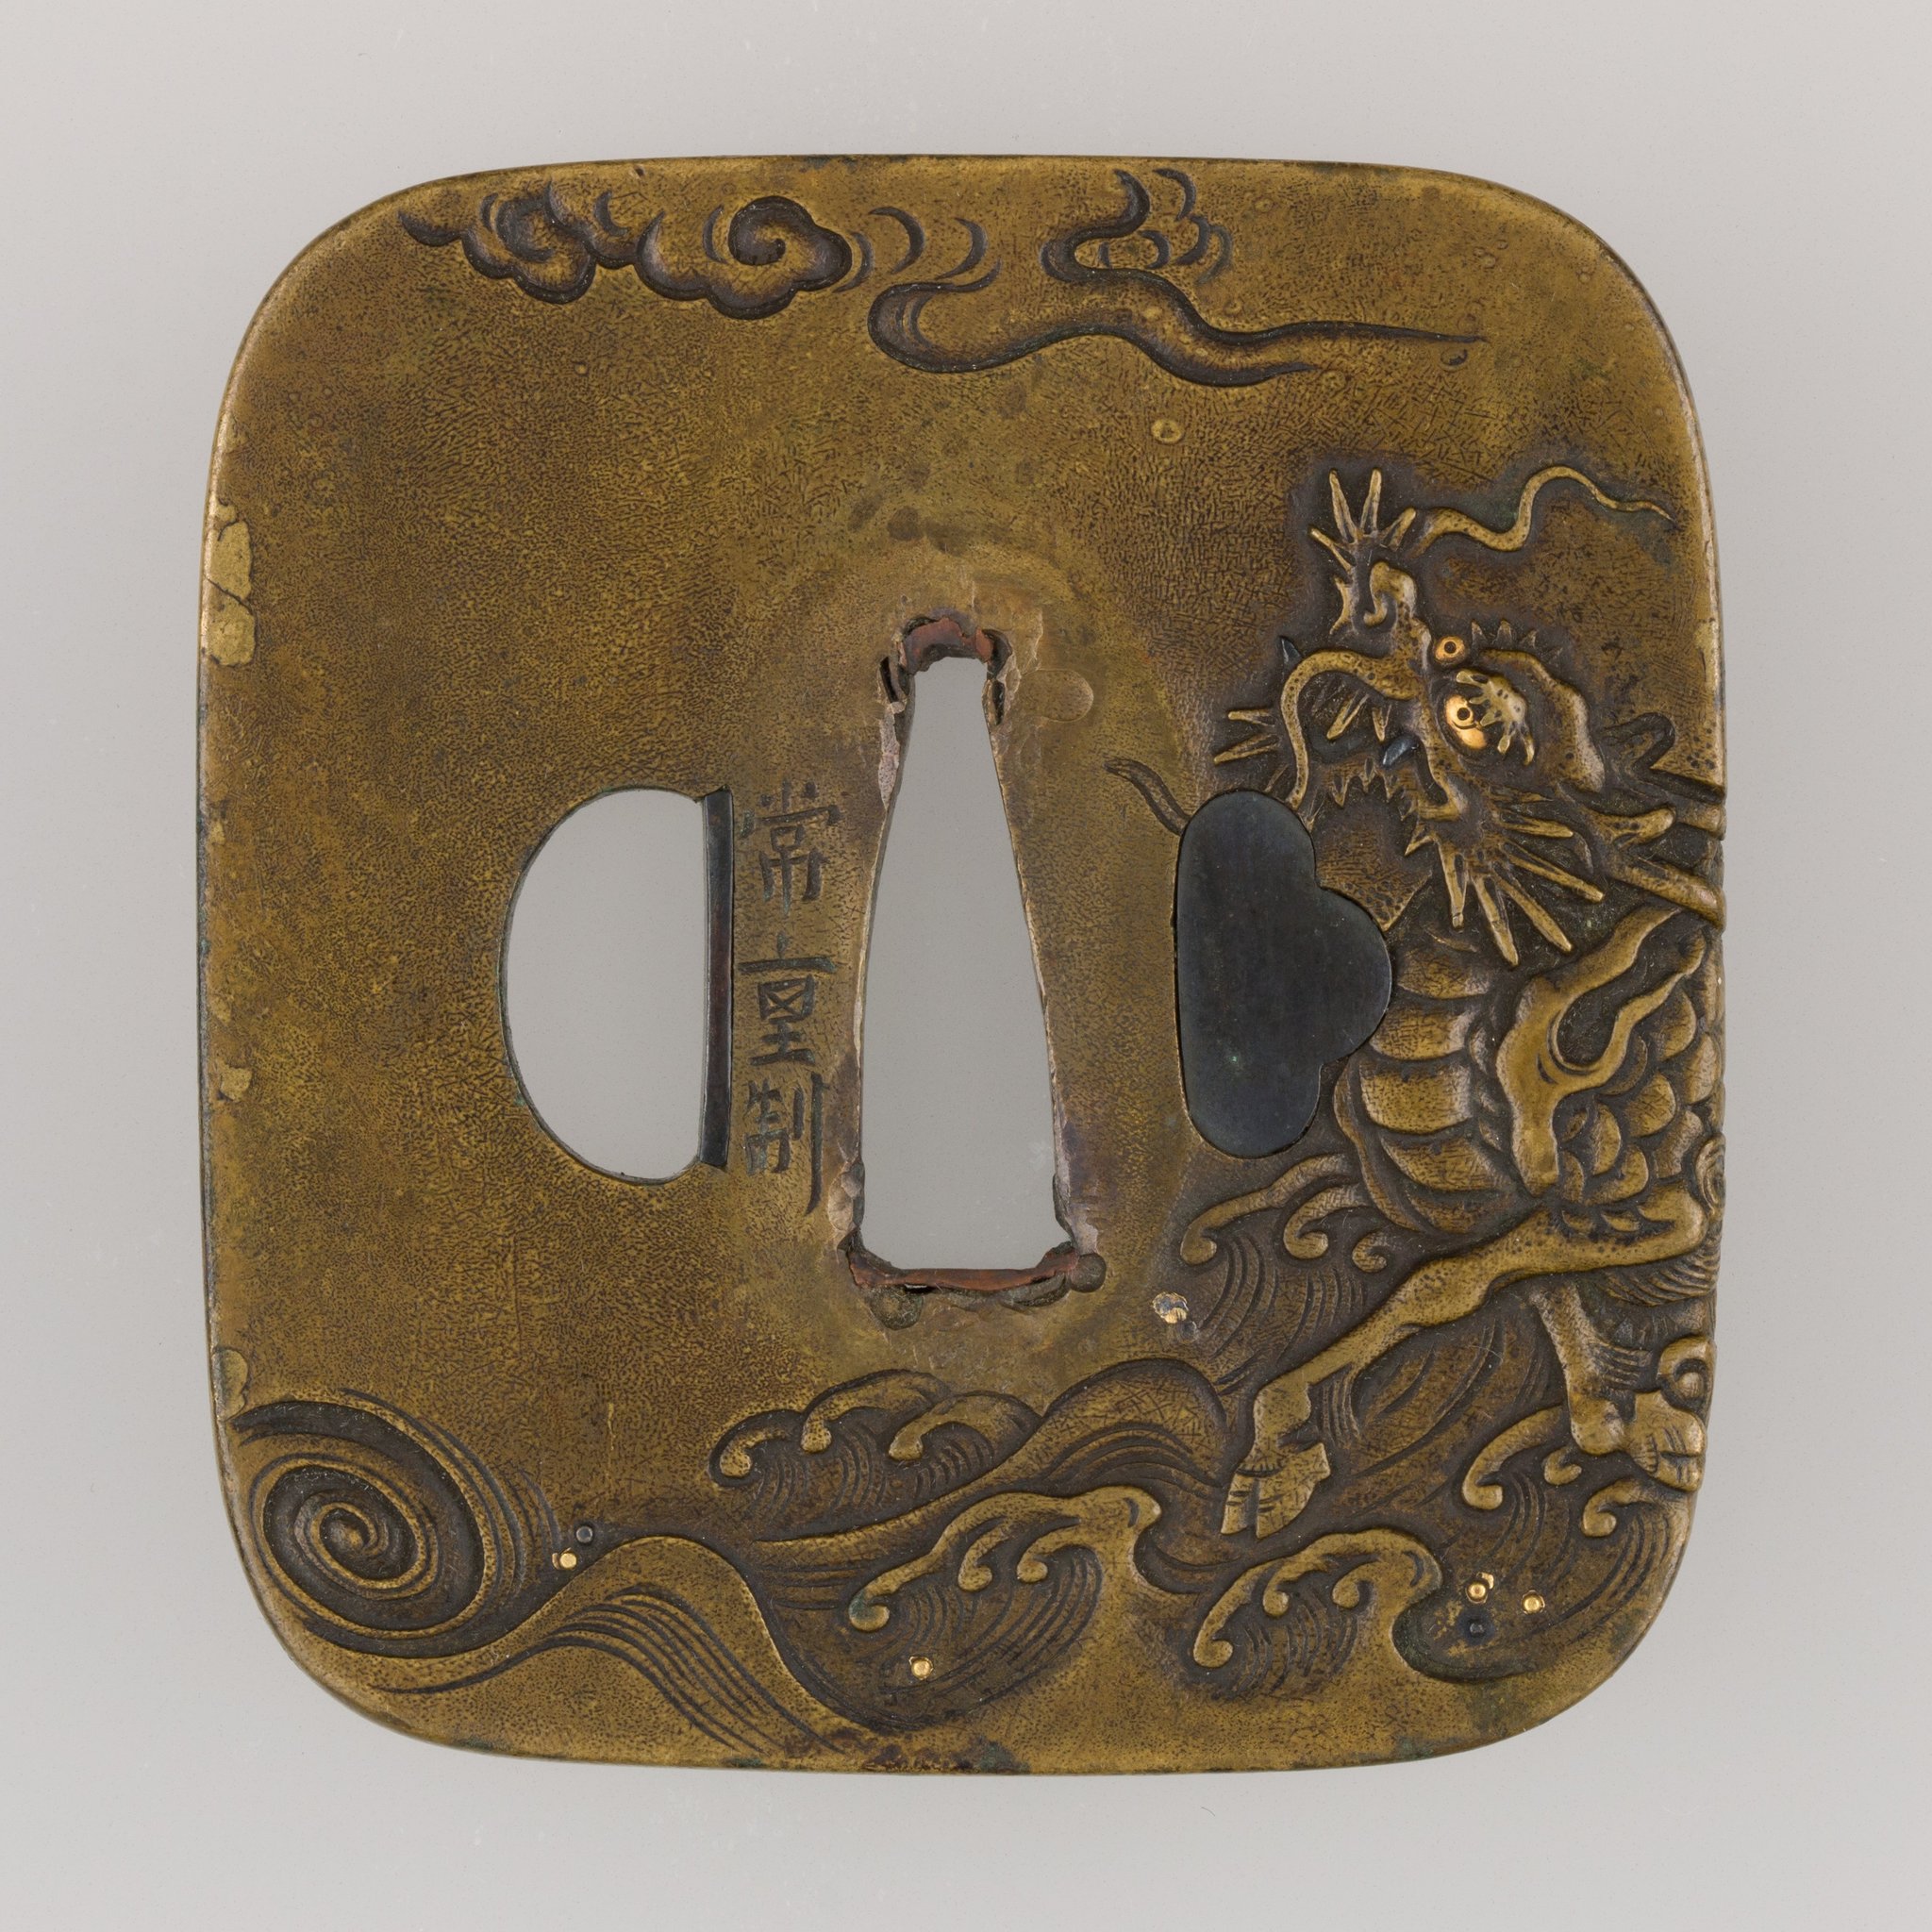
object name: sword guard tsuba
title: Sword Guard (Tsuba)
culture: japanese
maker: kawamura tsuneshige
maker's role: artist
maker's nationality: japanese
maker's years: 1750-1800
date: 1767-1800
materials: brass, copper, gold alloy, gold, silver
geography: japan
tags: mythical creatures